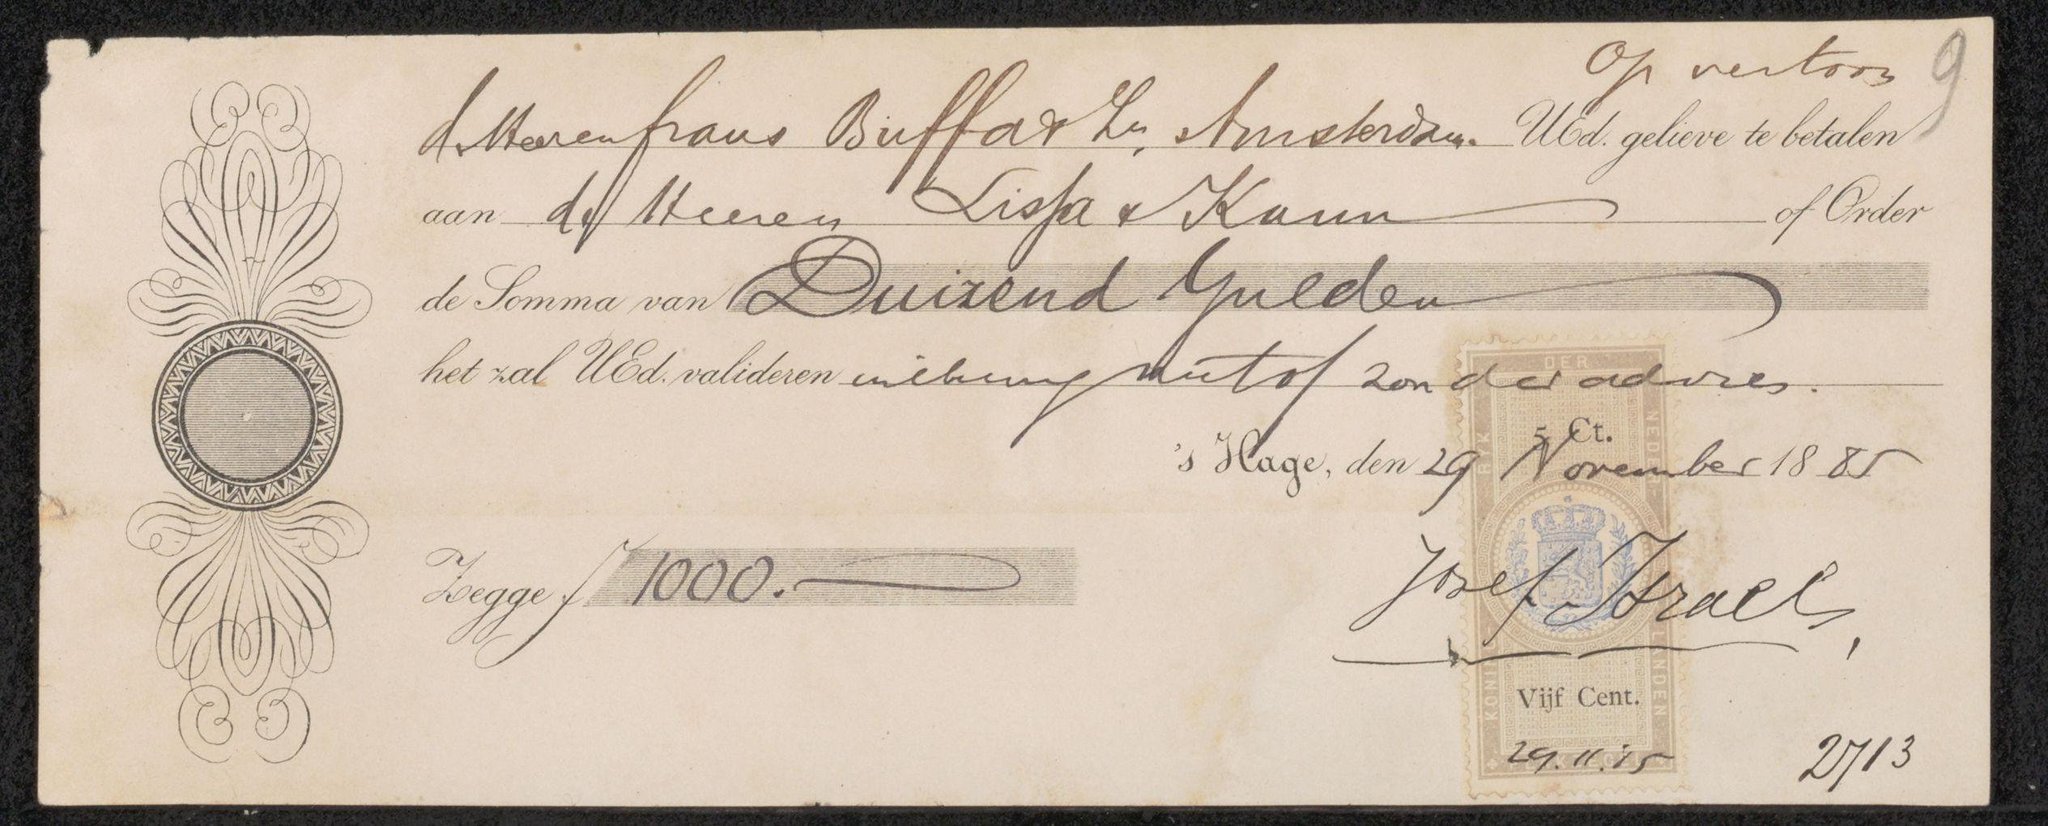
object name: ontvangstbewijs, kwitantie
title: Kwitantie voor Frans Buffa en Zonen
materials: ink, paper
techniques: pen, printing, writing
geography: the hague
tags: money, amsterdam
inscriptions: collector's mark: Lugt 2233